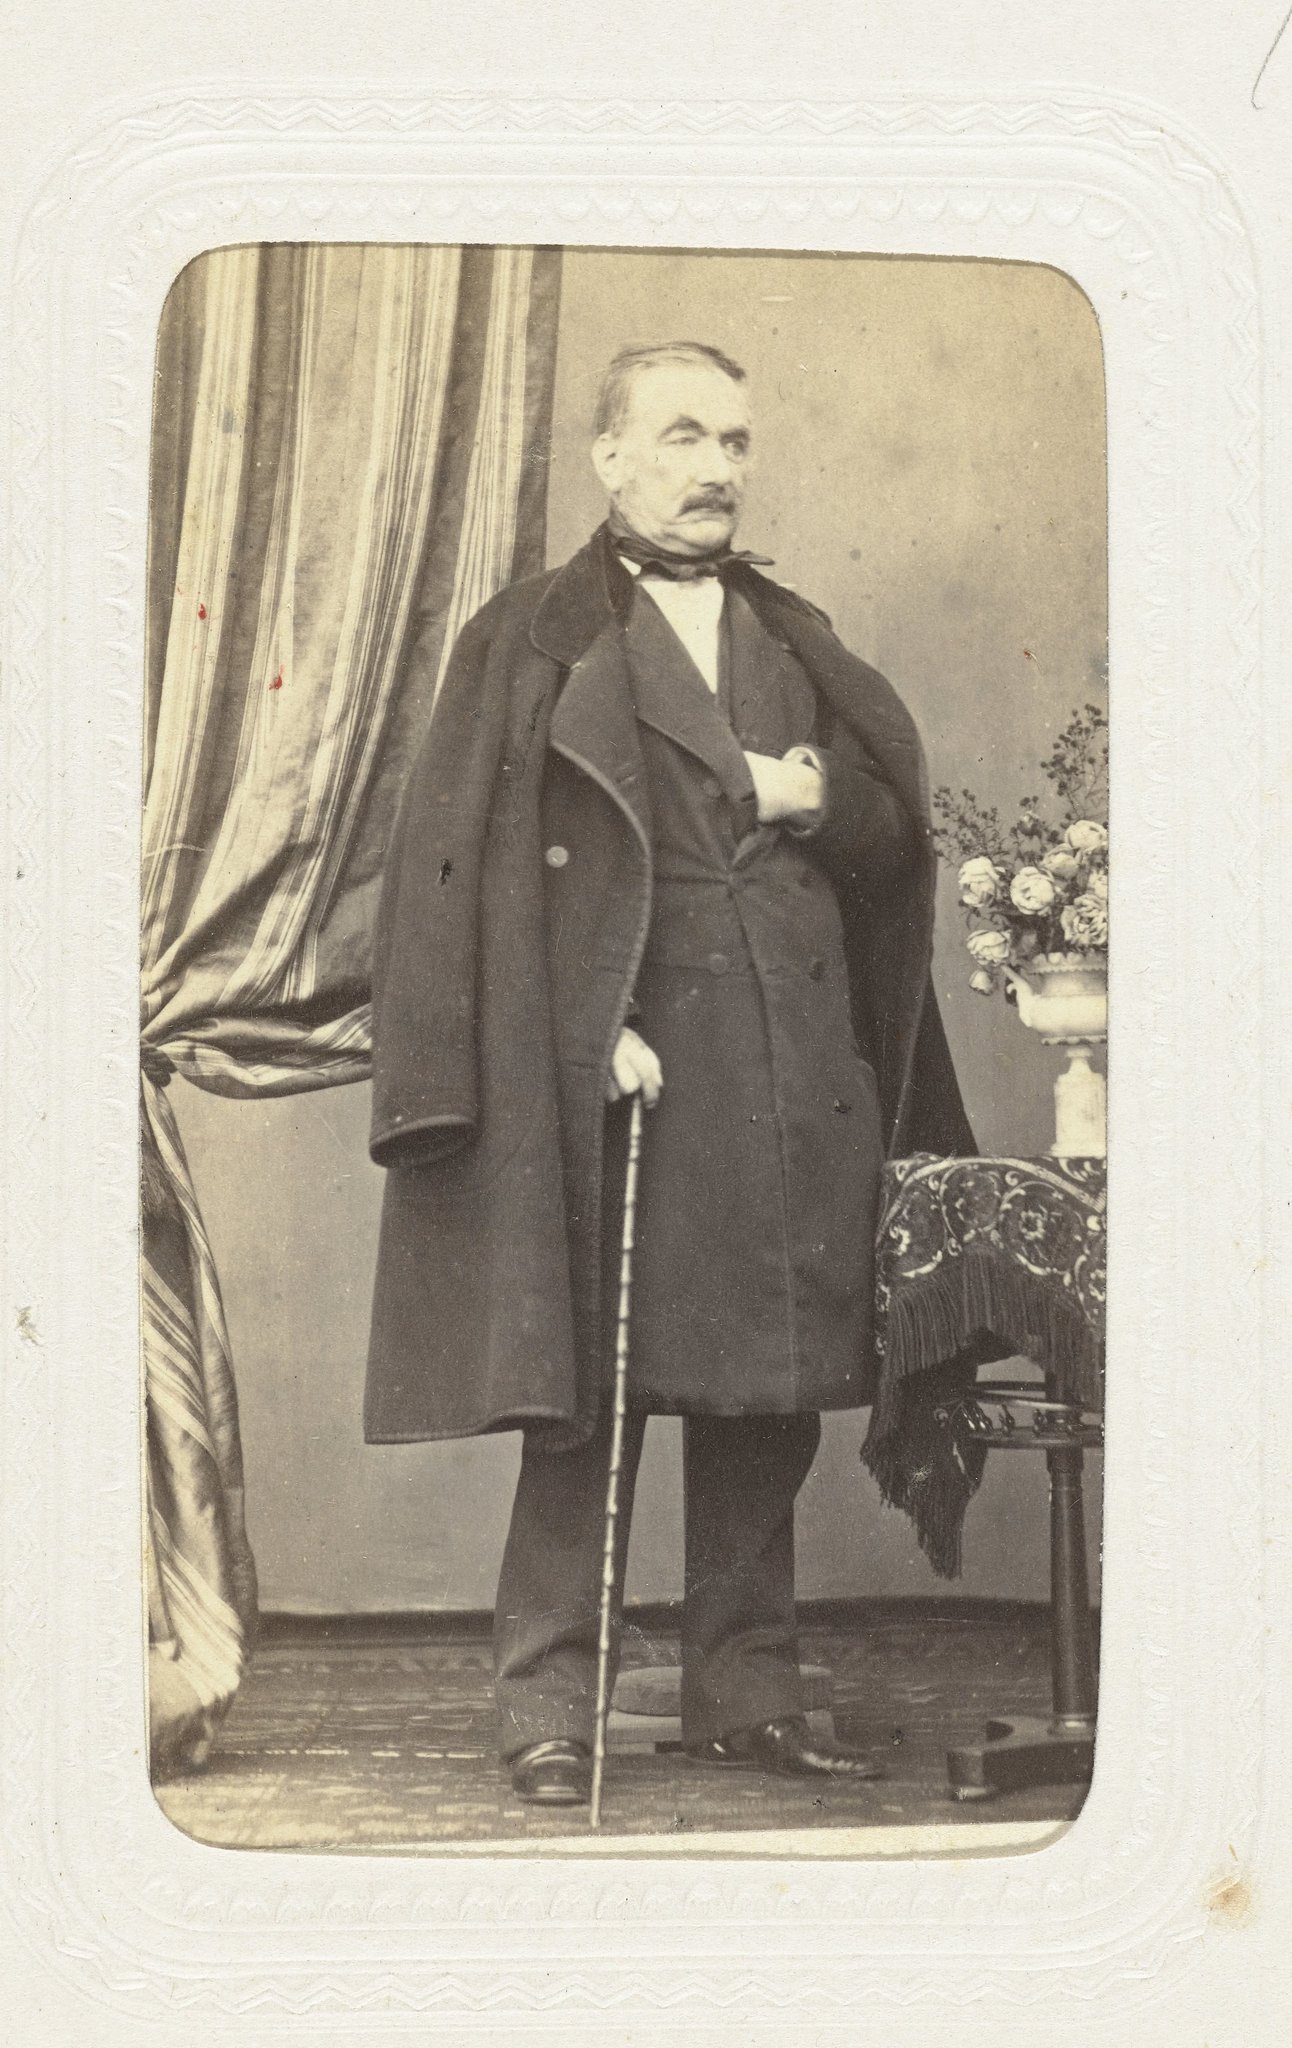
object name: carte de visite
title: Studioportret van een oudere man in kostuum met overjas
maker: Anonymous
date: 1863-1866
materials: cardboard, paper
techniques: albumen print